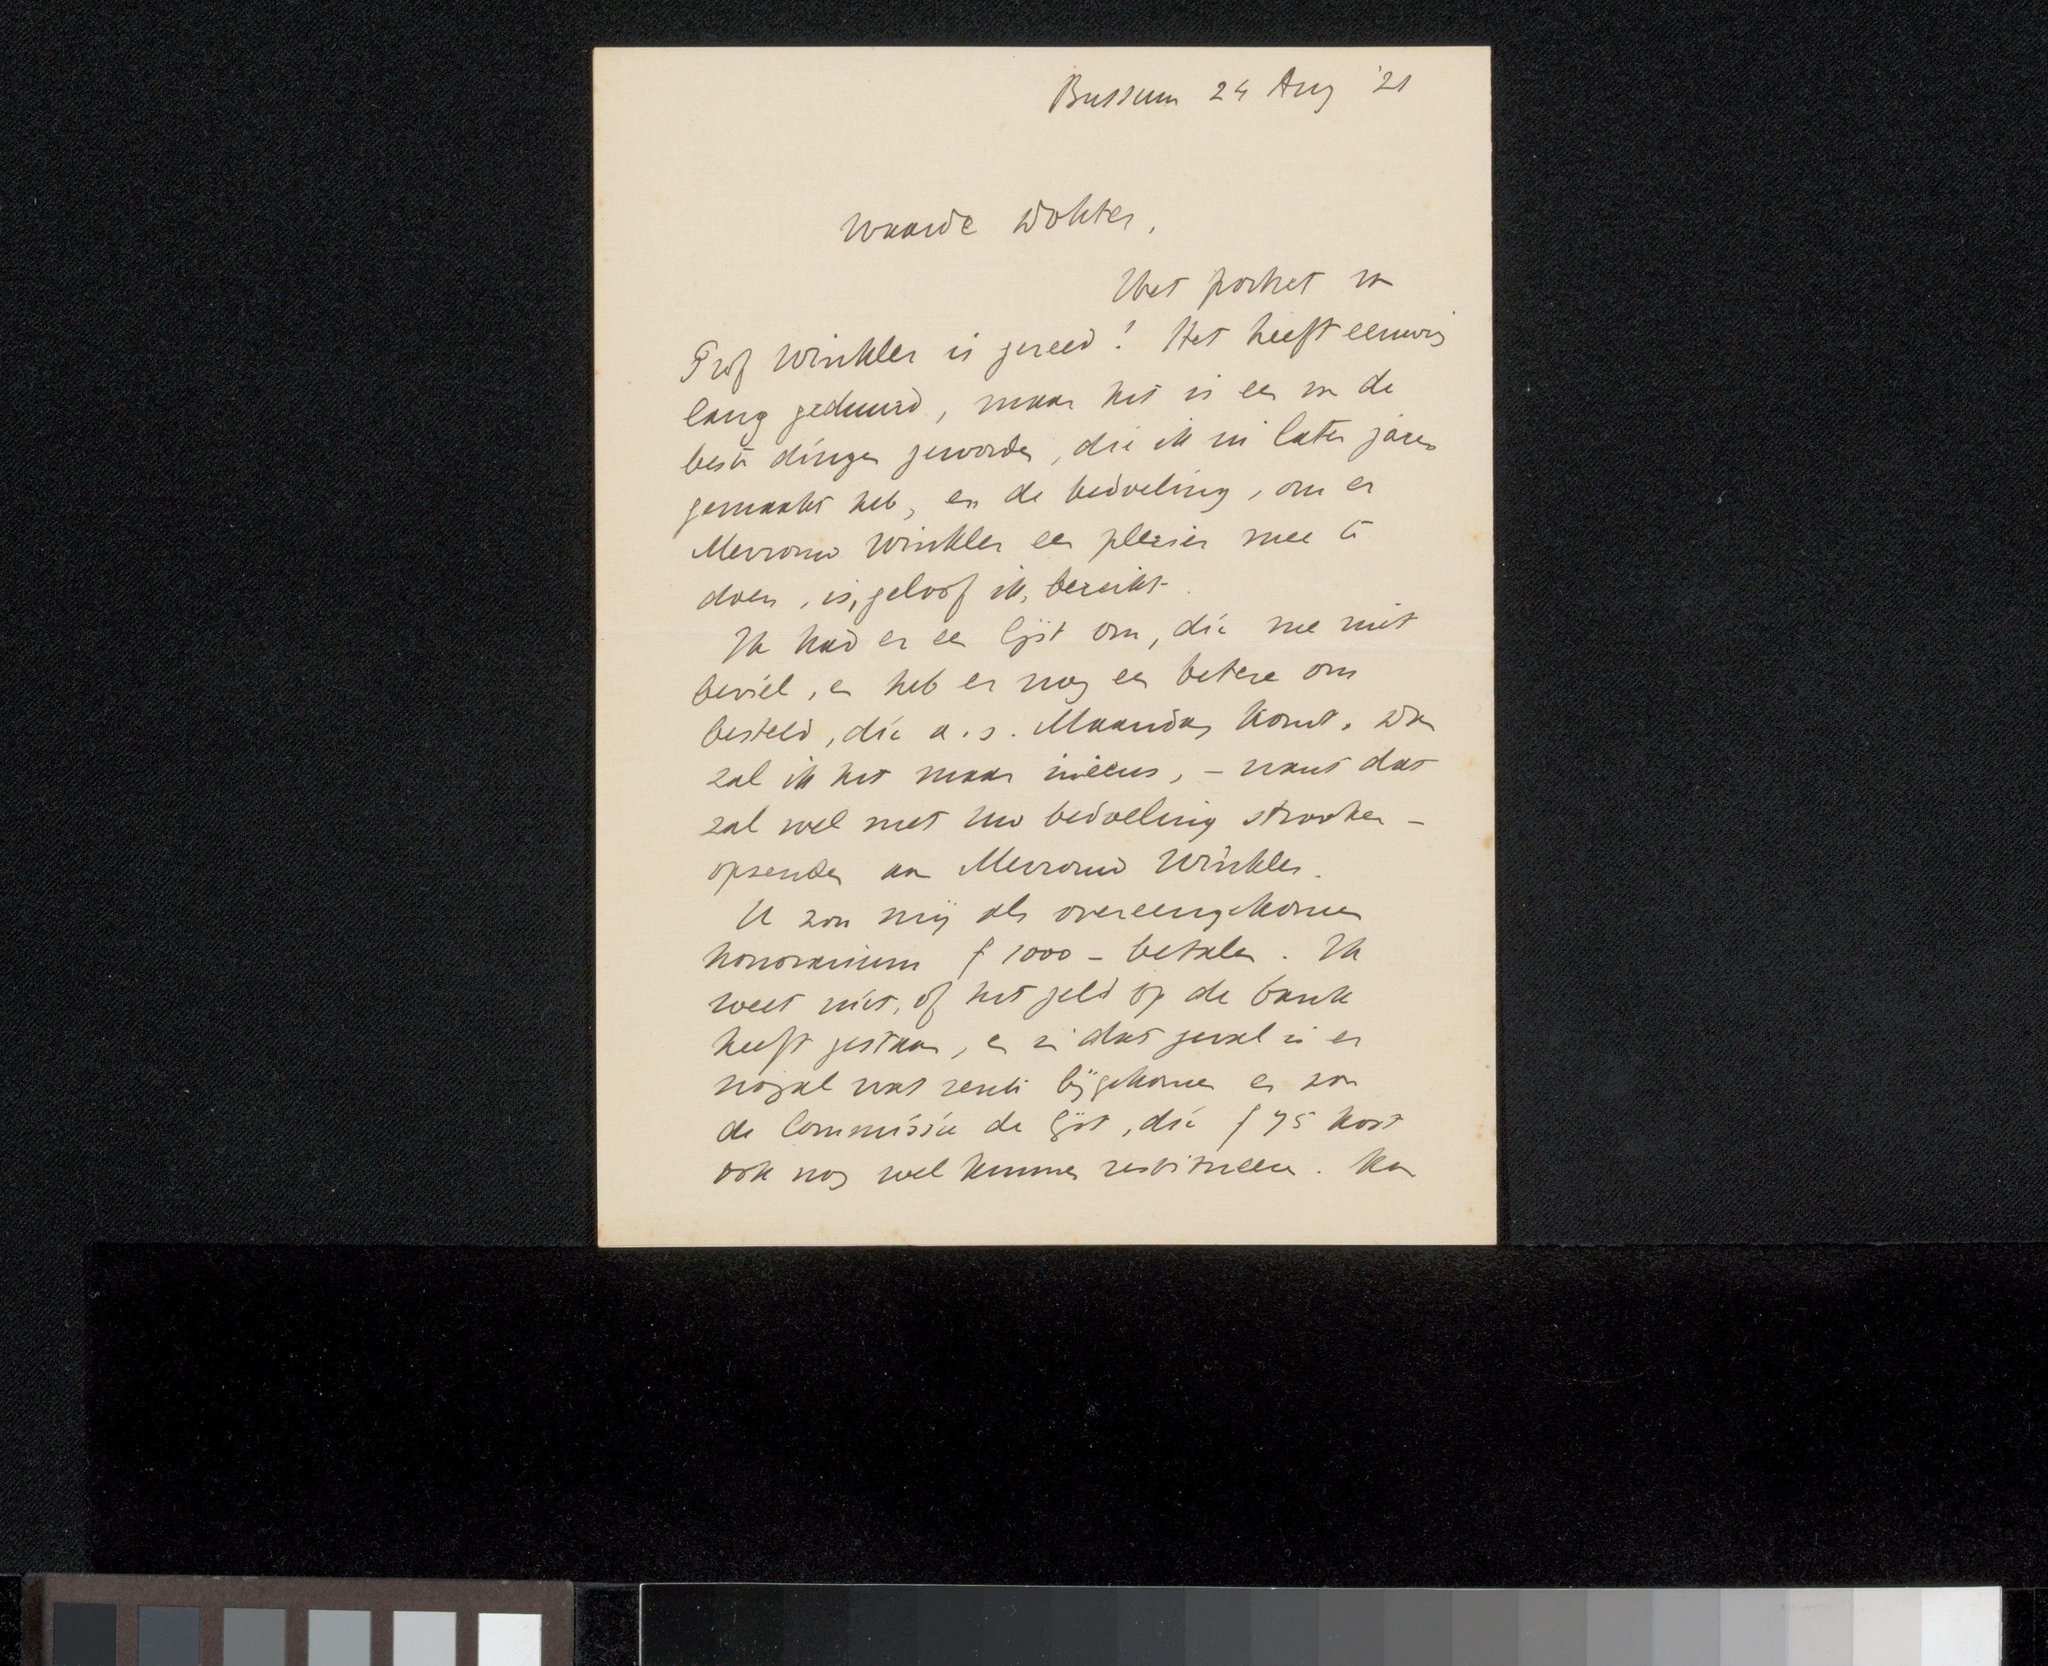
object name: letter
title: Brief aan C.C. Delprat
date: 1921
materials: ink, paper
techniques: pen, writing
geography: bergen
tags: amsterdam, c.c. delprat, cornelis winkler, historical persons (portraits and scenes from the life), money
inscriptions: collector's mark: ‘RPK’, watermark